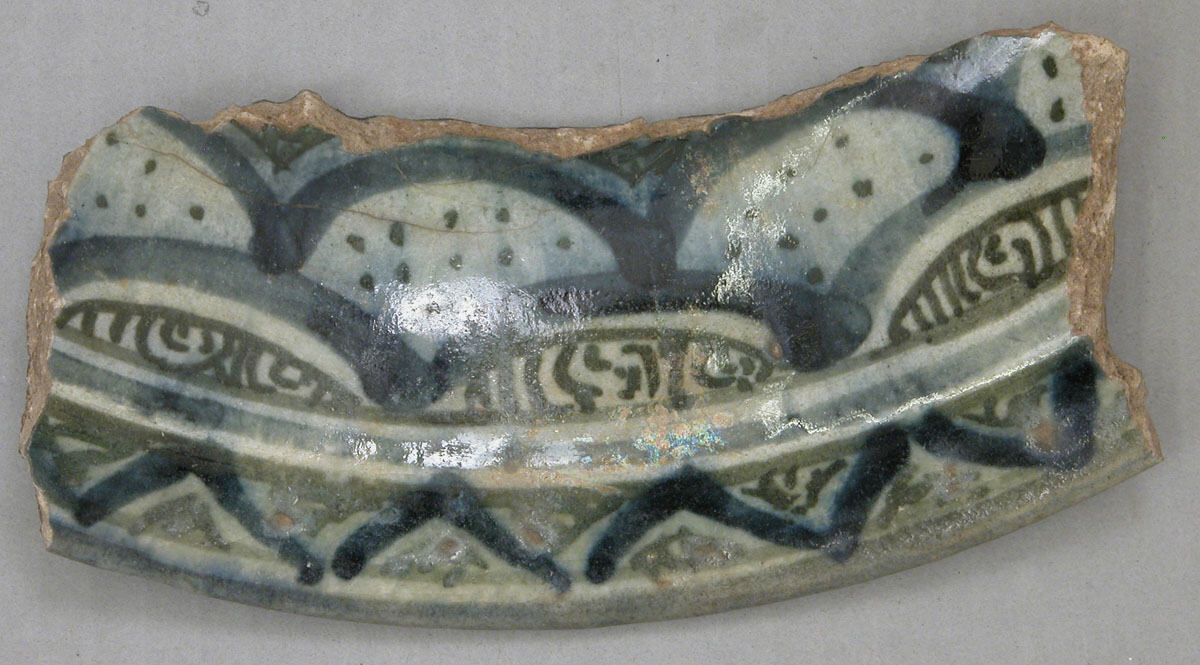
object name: fragment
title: Ceramic Fragment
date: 1301-1400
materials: glaze, stonepaste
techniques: painting, polychrome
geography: syria